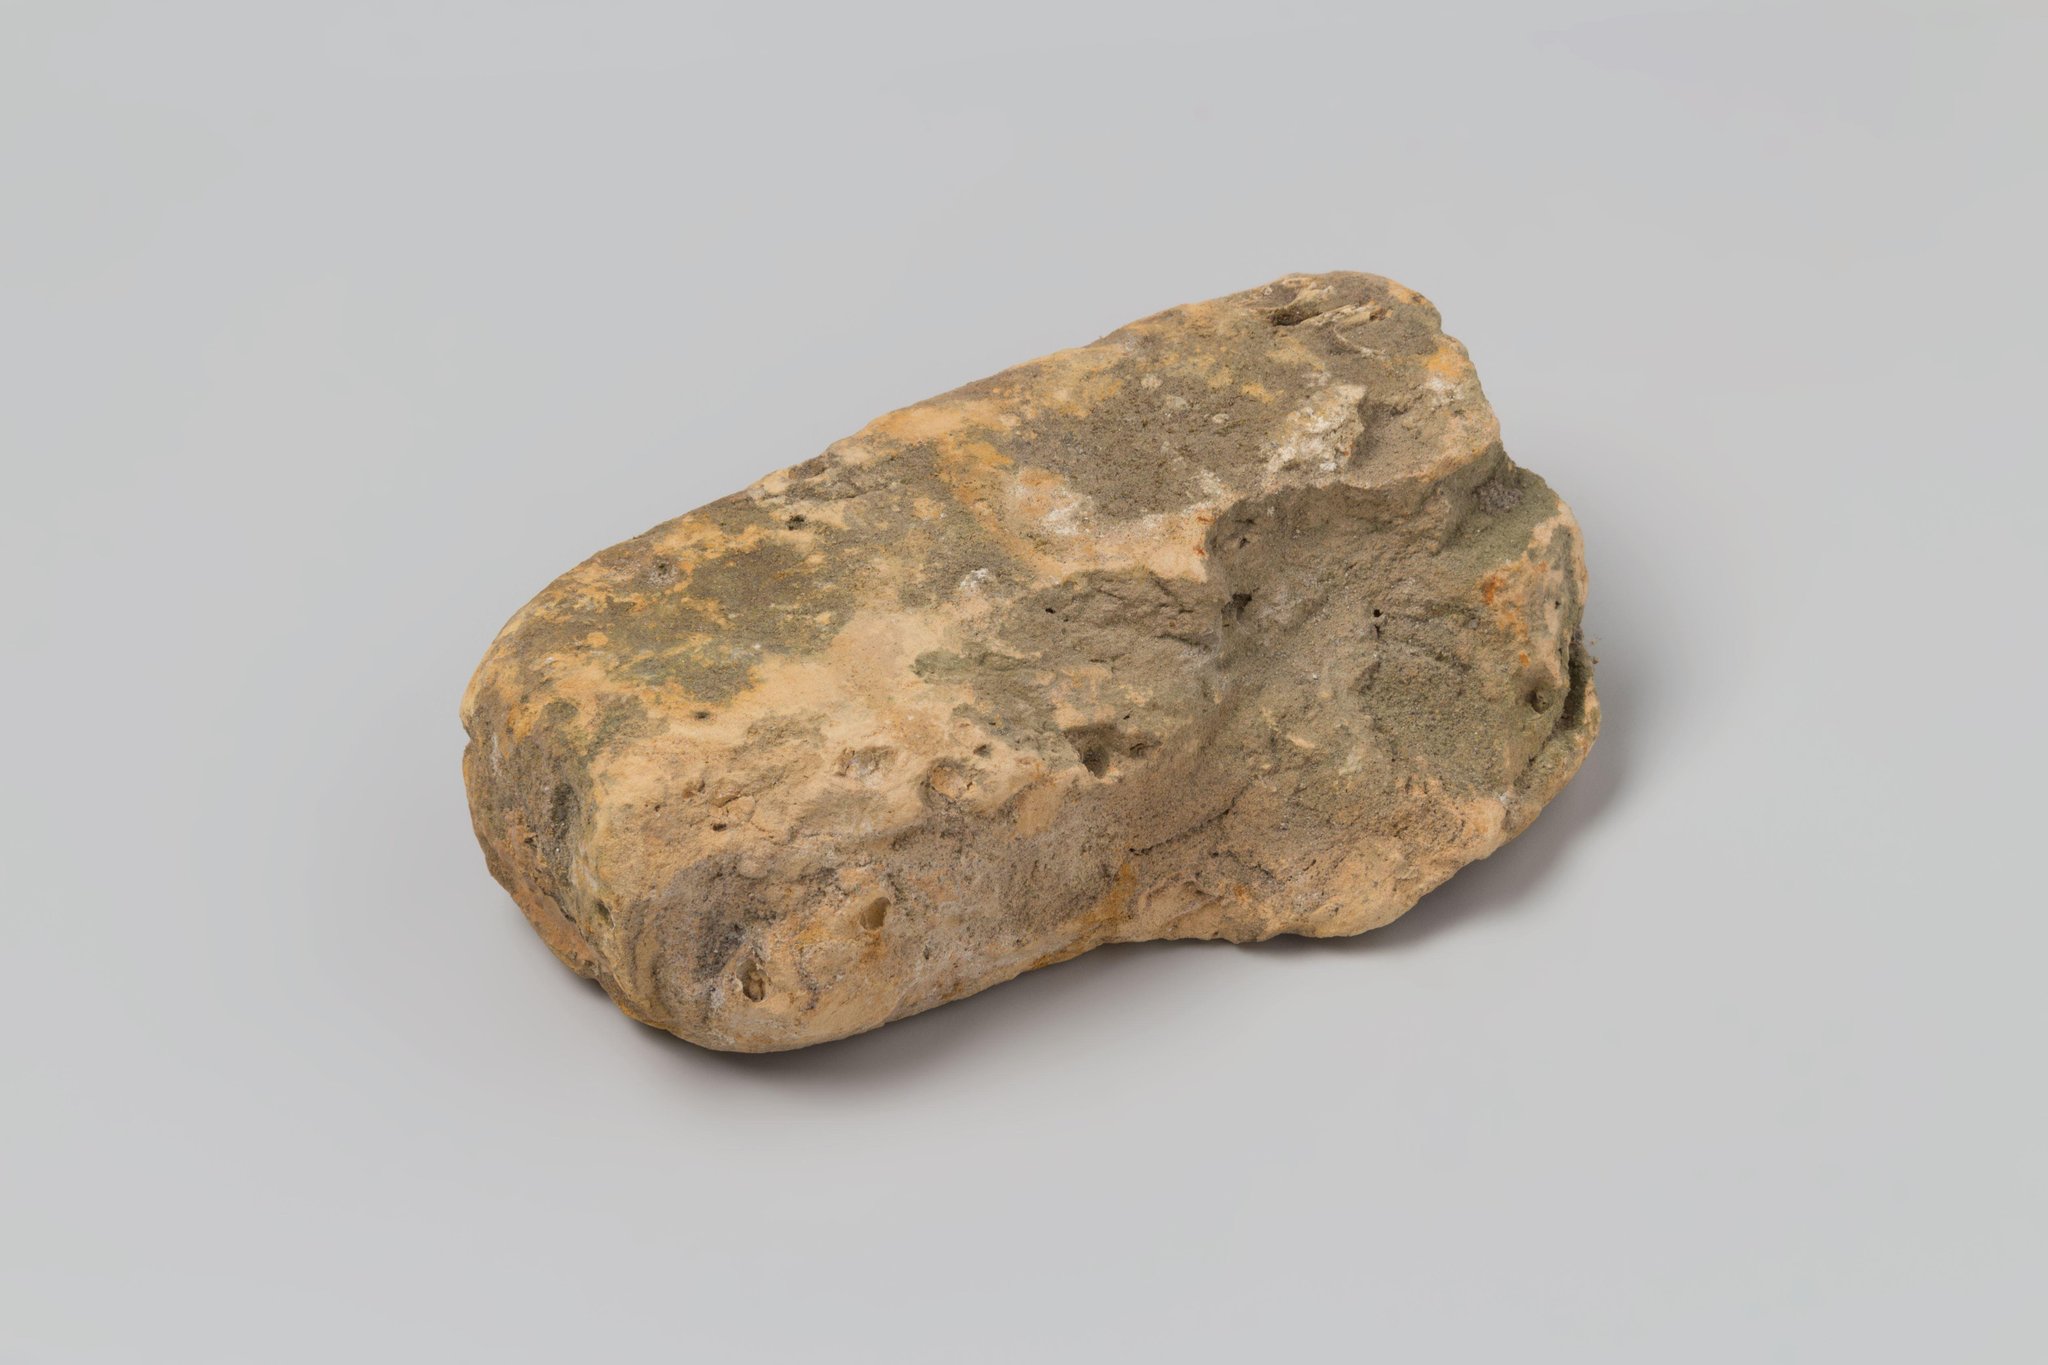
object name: brick clay product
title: Deel van een baksteen uit het wrak van de Oost-Indiëvaarder 't Vliegend Hart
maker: Anonymous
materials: brick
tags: 't vliegend hart (schip), verenigde oostindische compagnie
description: Deel van een rechthoekige, geelbruine baksteen. Brick.